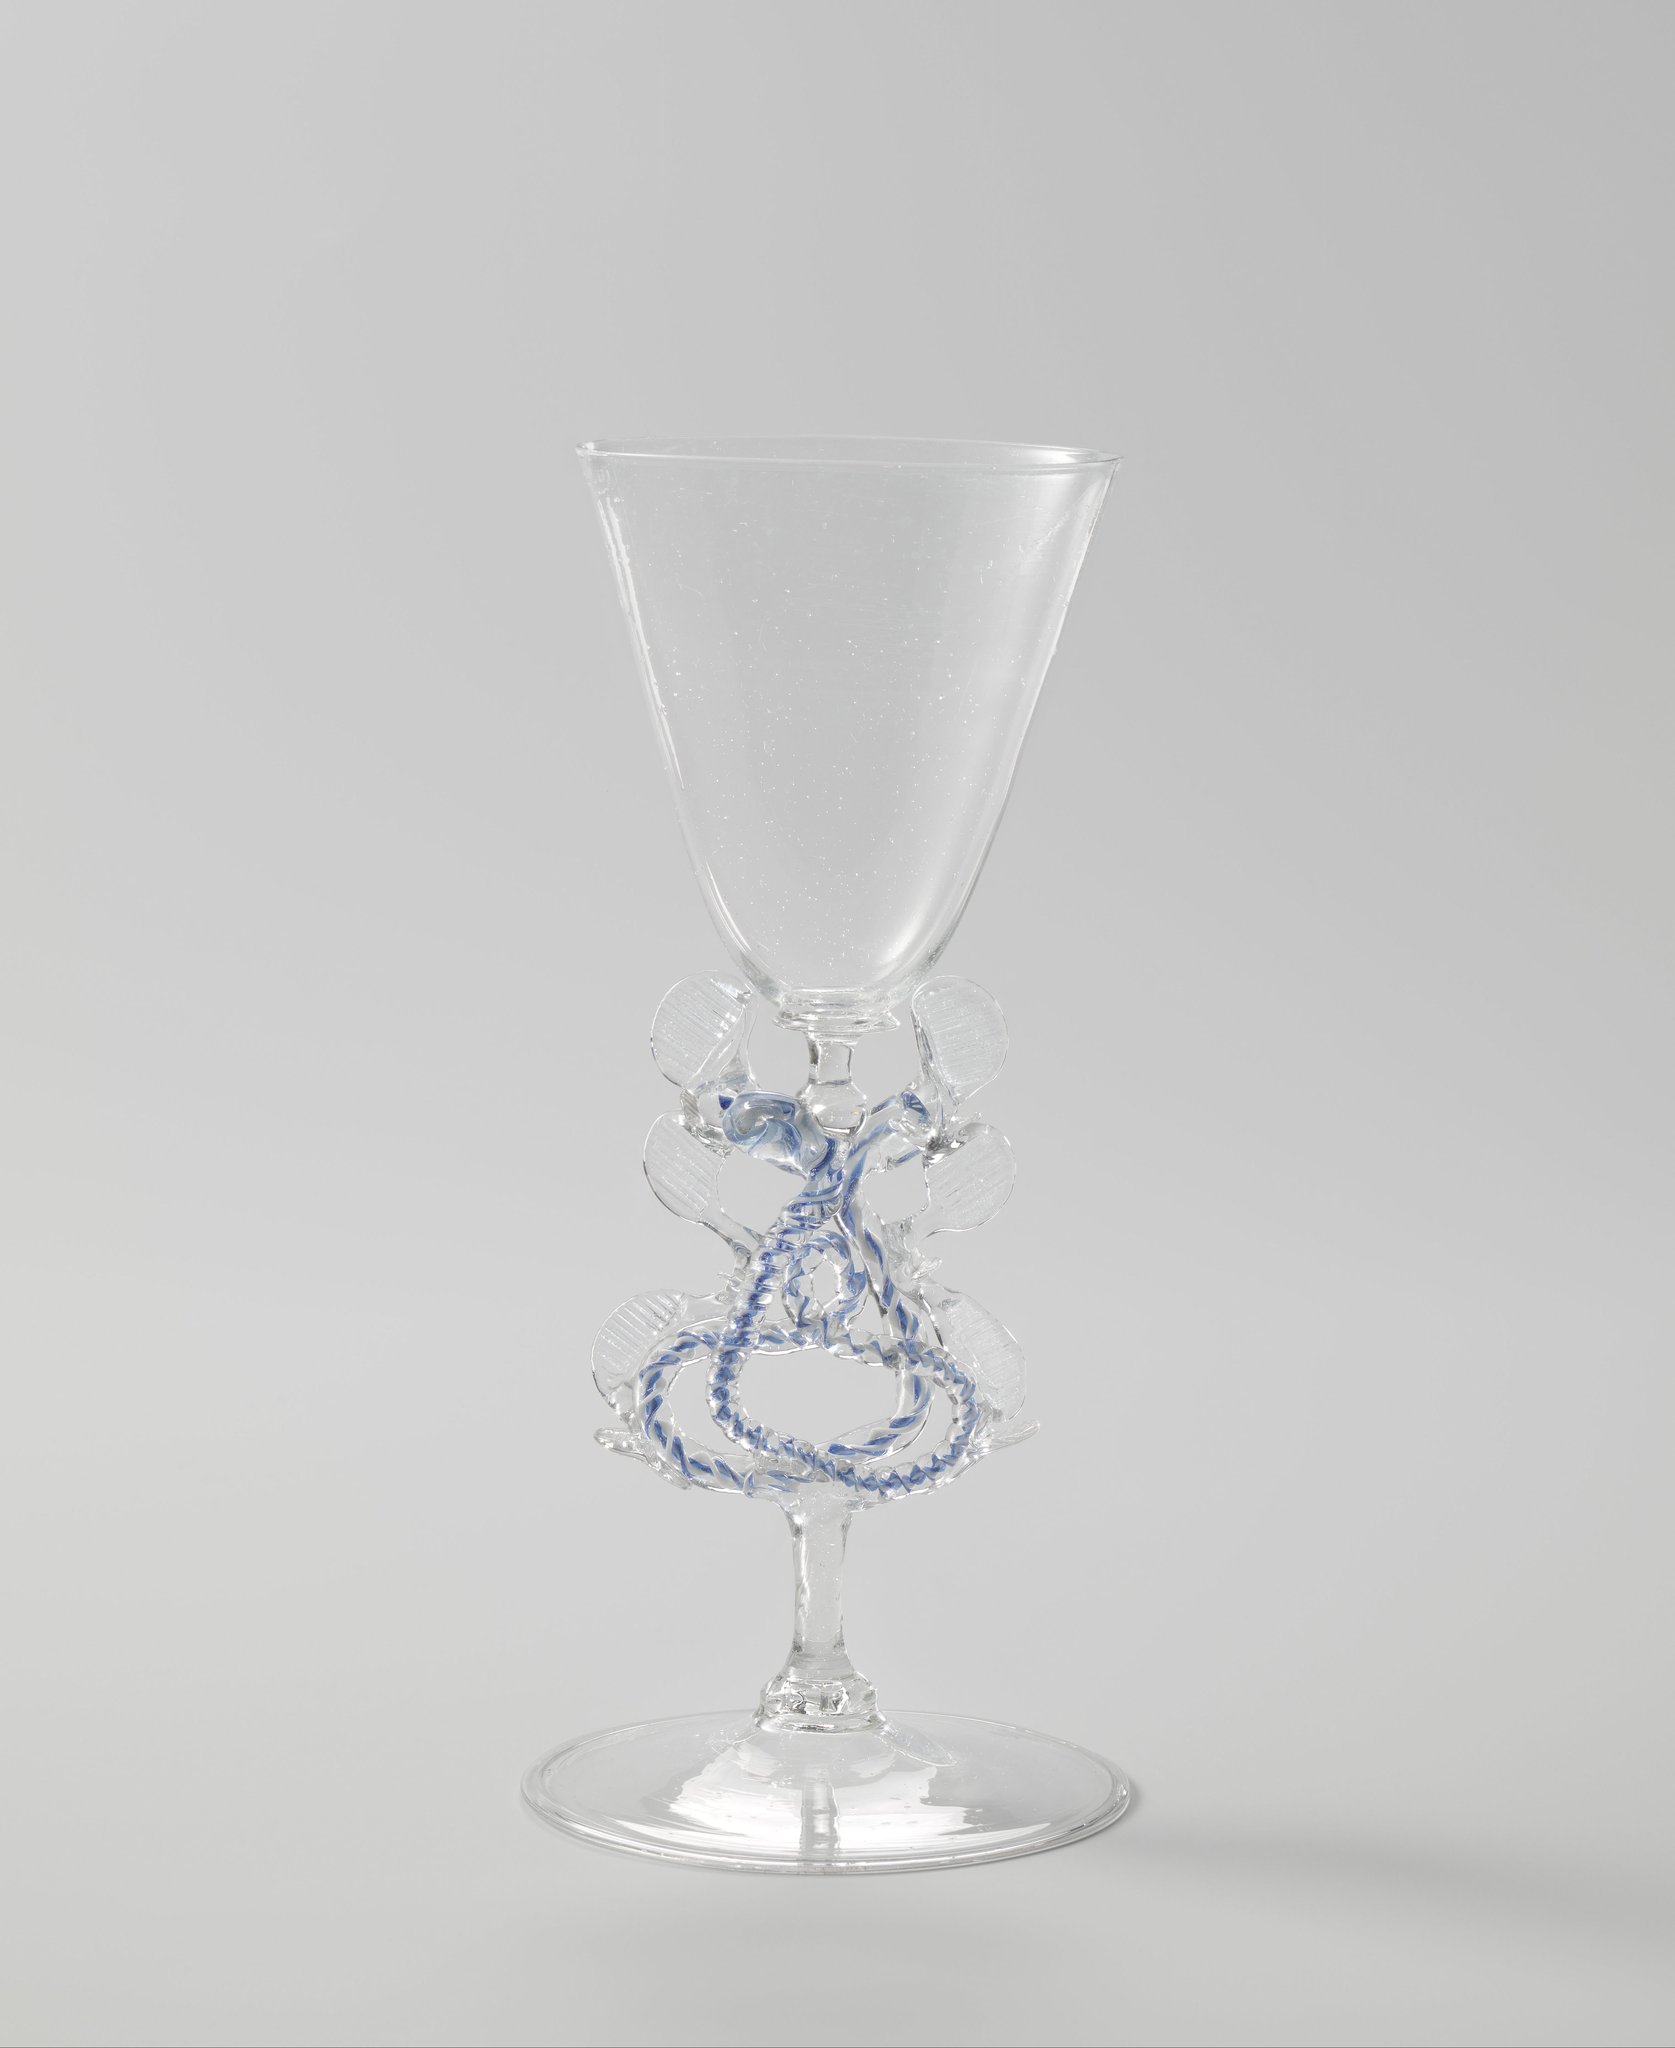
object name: vleugelglas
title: Flügelglas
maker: Anonymous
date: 1650-1700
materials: glass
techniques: façon de venise, glassblowing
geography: netherlands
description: The stem of this glass consists of a hollow blown thread of transparent and blue glass, symmetrically twisted in complex loops. Because of the shape of the stem resembles bird or insect wings, this form is known in English by the German term Flügelglas (‘winged glass’).